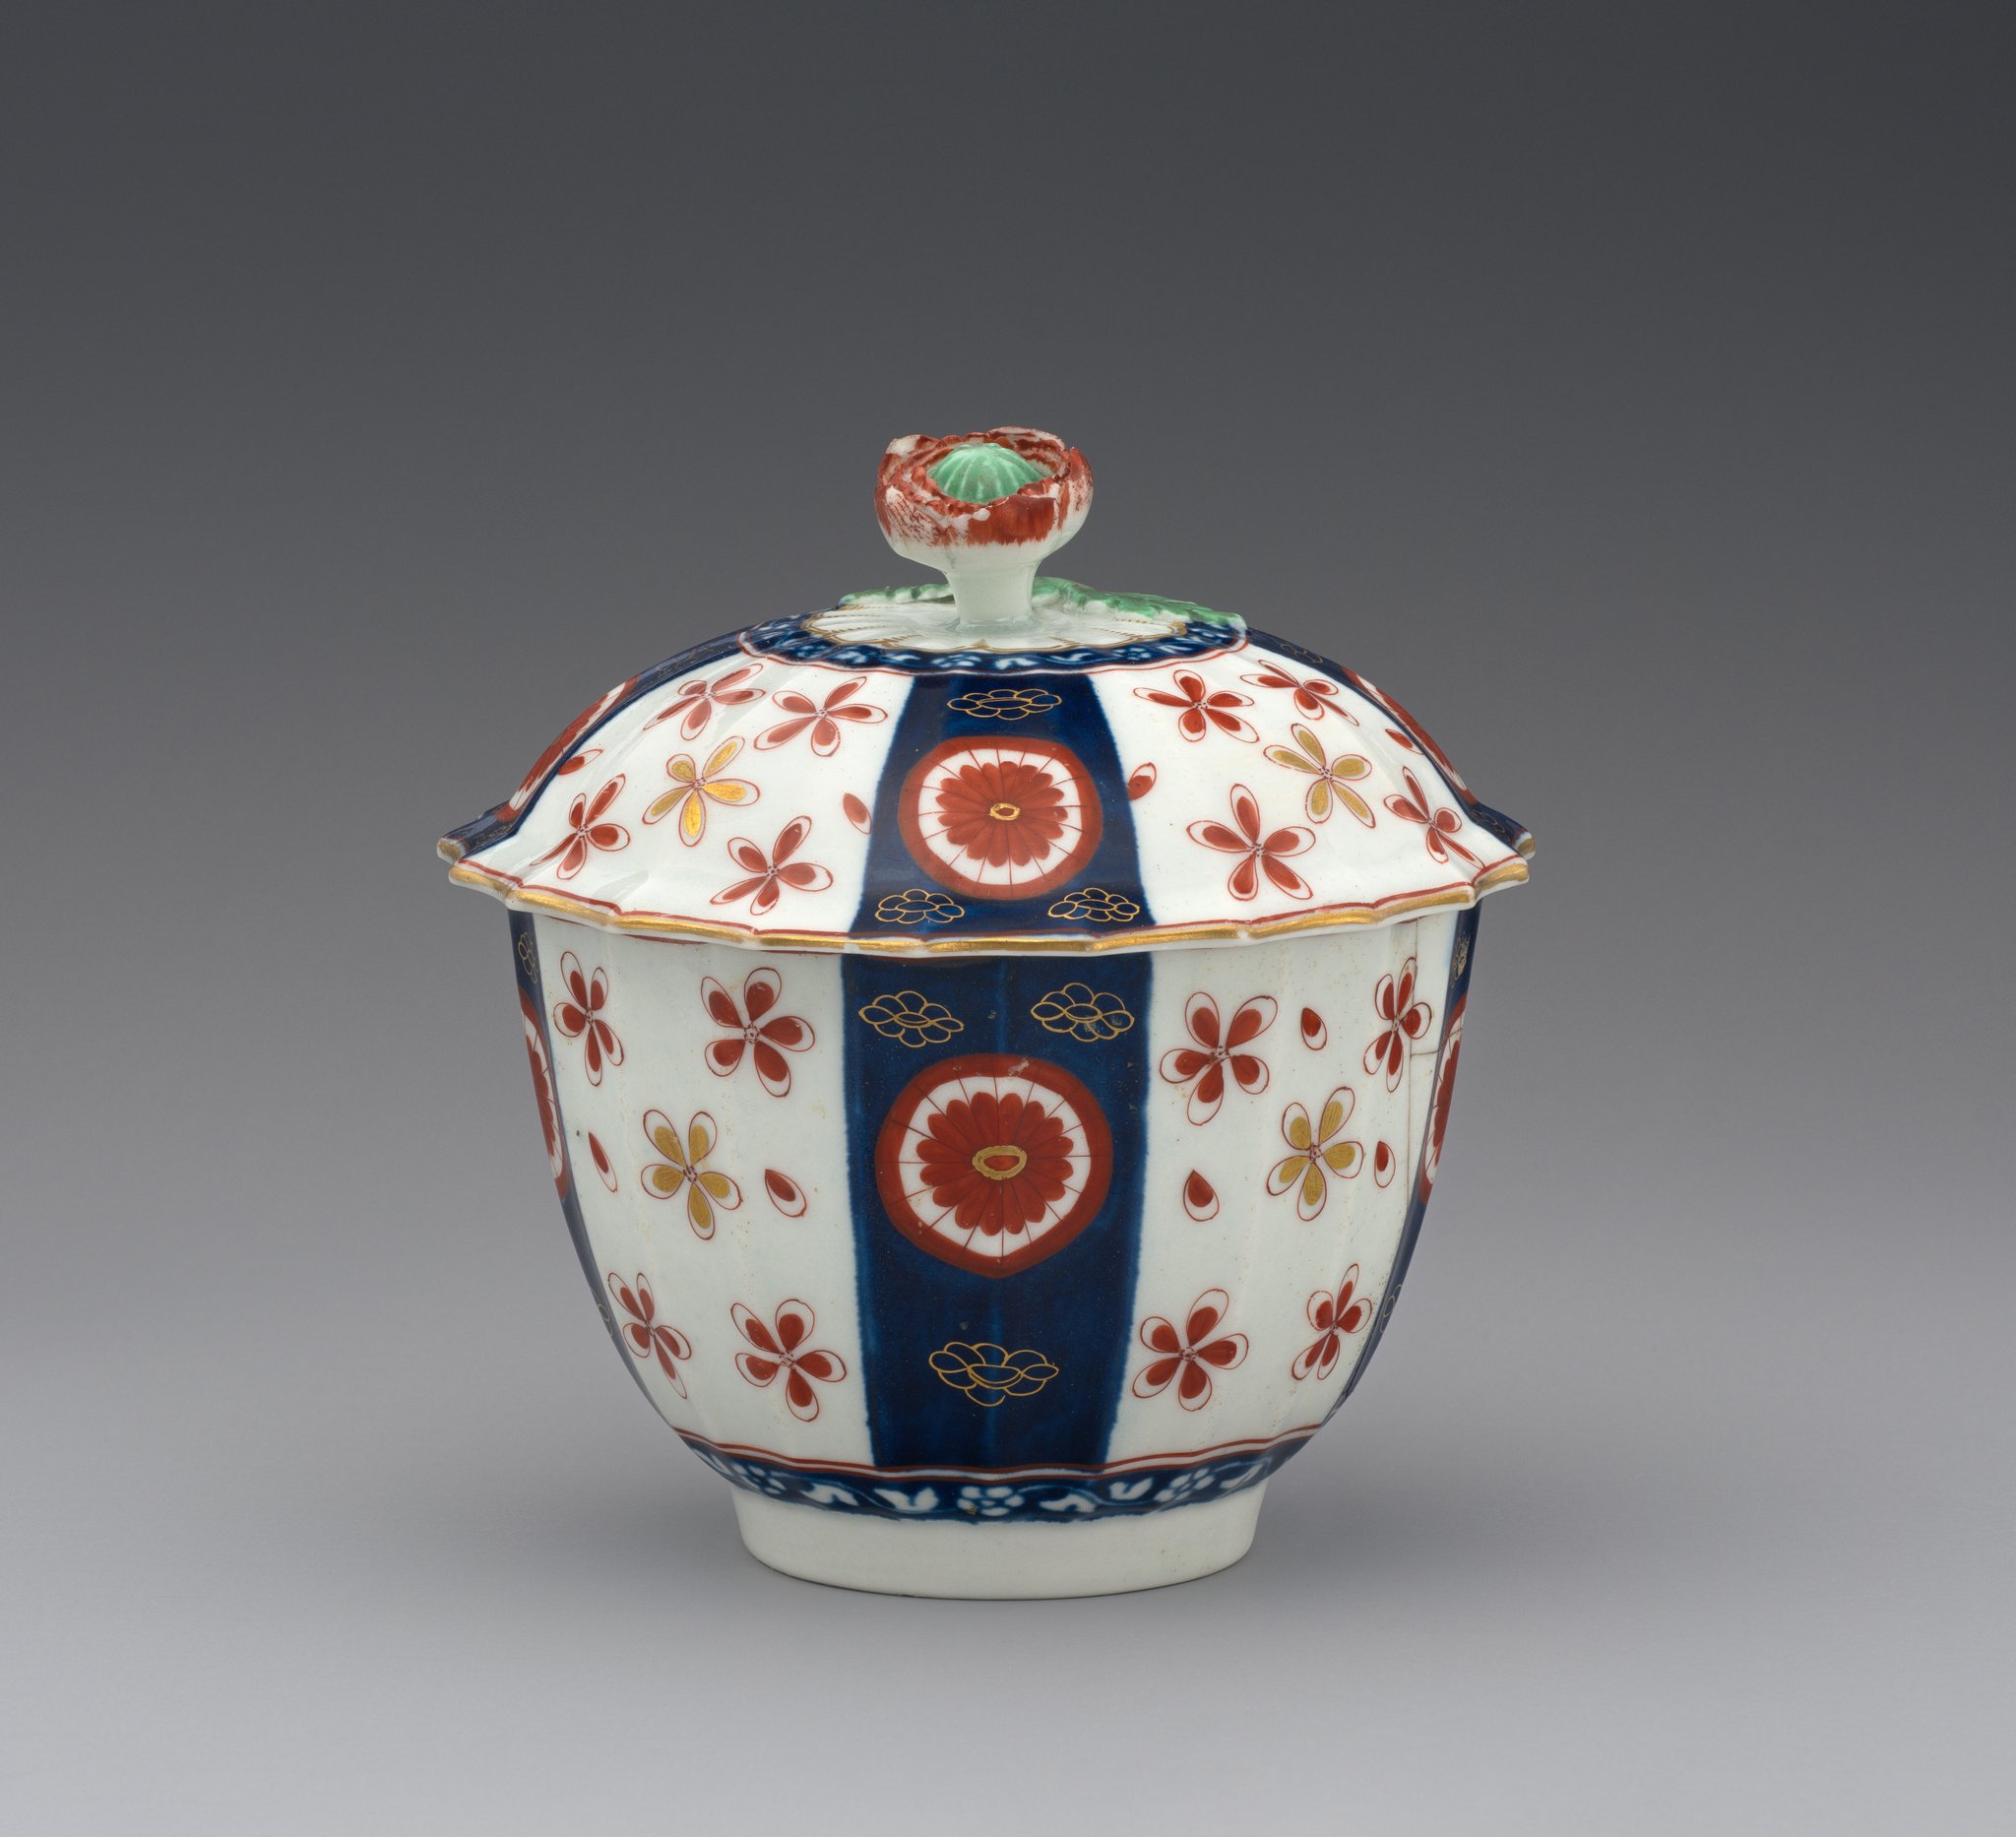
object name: sugar bowl with cover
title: Sugar bowl with cover (part of a service)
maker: worcester factory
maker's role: factory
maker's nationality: british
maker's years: 1751-2008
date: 1765-1775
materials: soft paste porcelain